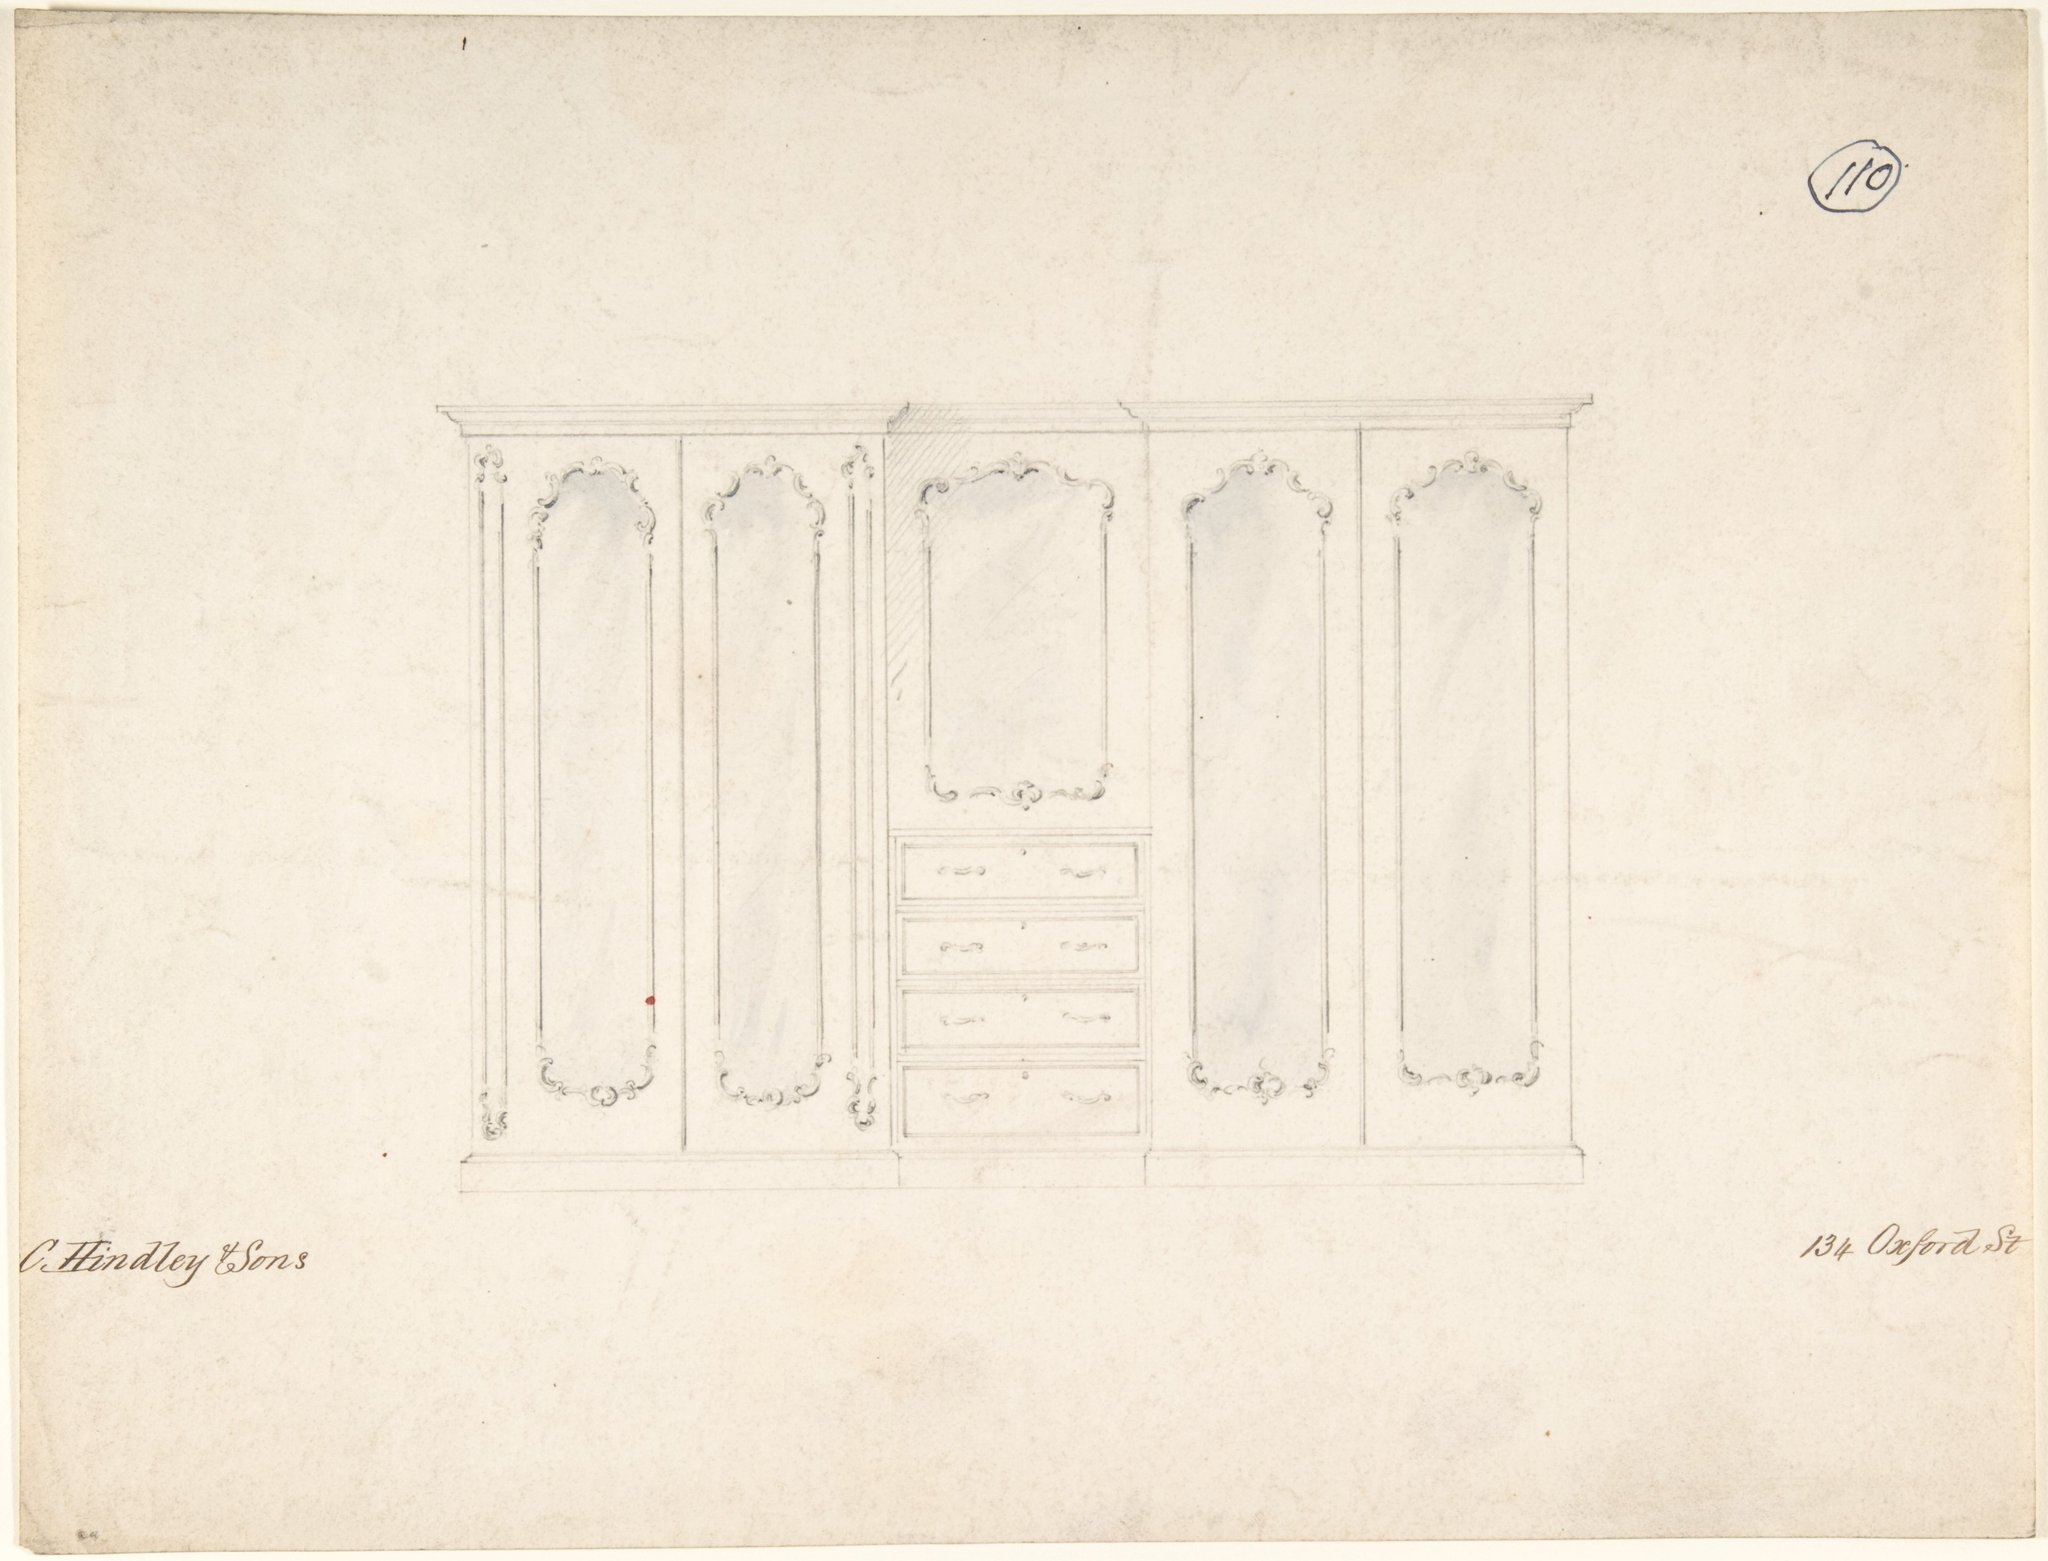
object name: drawing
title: Design for Armoire with Mirrors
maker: charles hindley and sons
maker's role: artist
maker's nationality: british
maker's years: 1841-1917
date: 1841-1884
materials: graphite, ink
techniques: brush, wash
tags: furniture